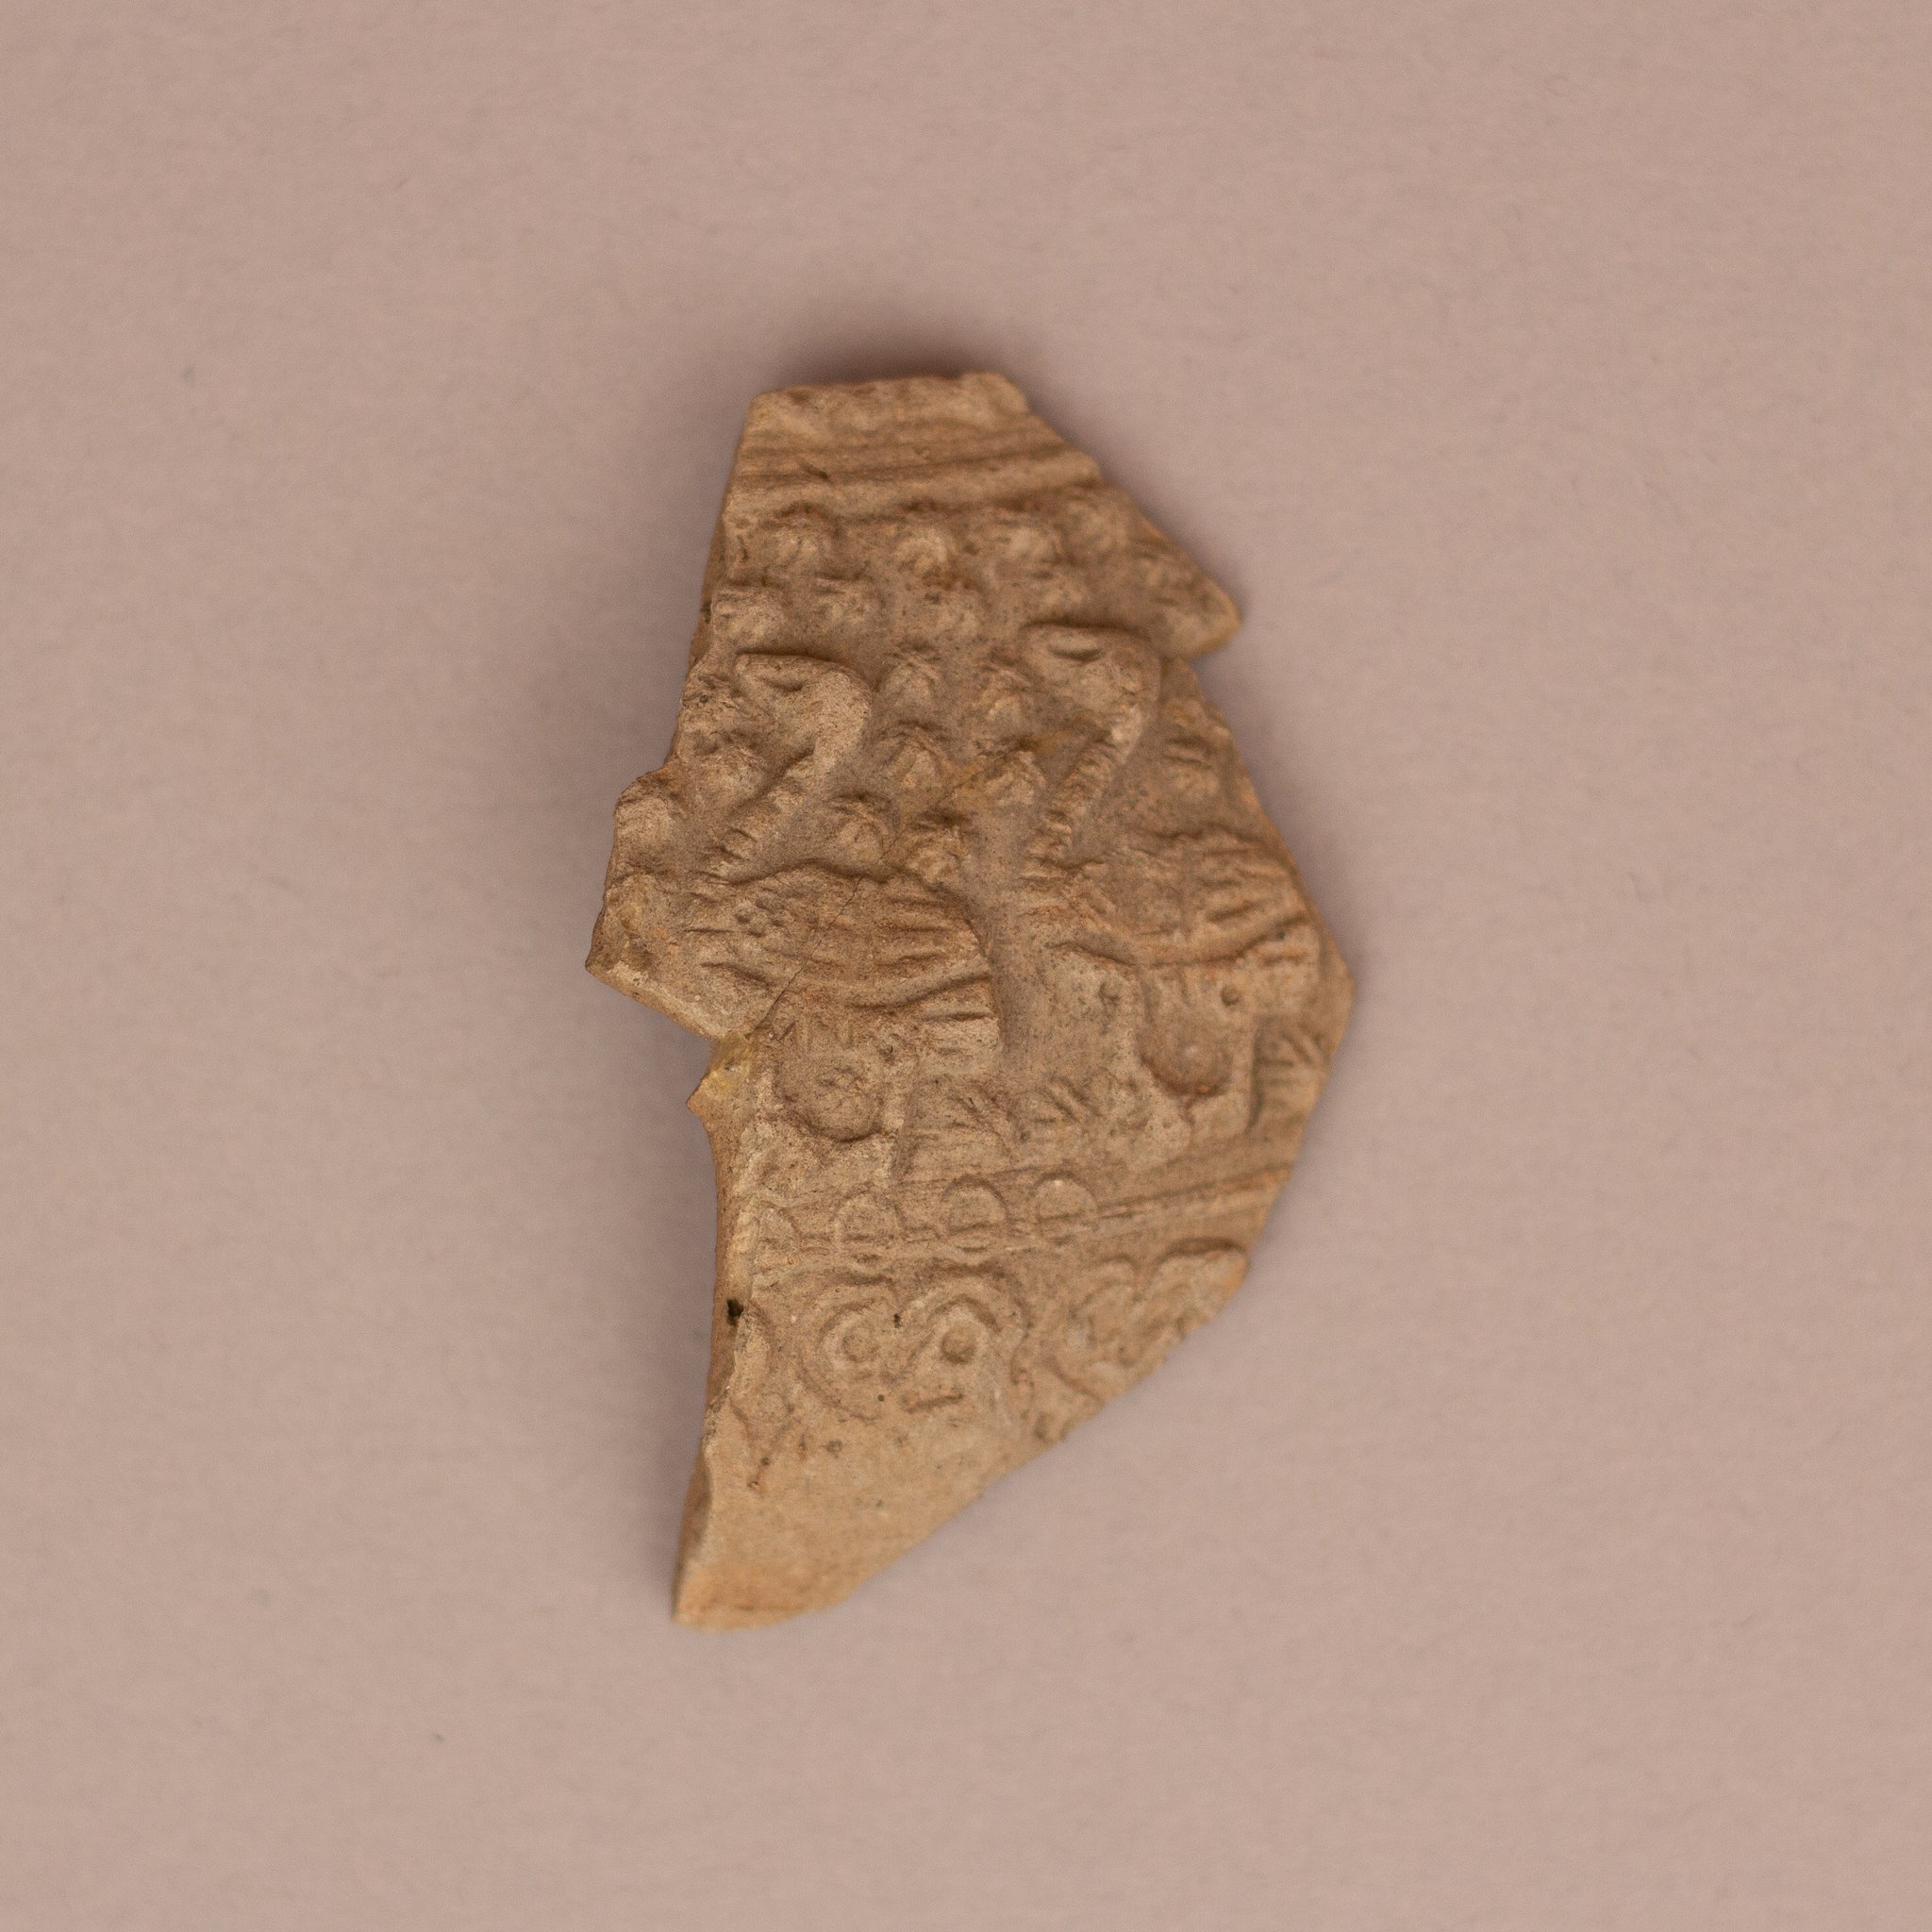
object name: fragment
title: Ceramic Fragment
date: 901-1100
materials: earthenware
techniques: molding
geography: iran